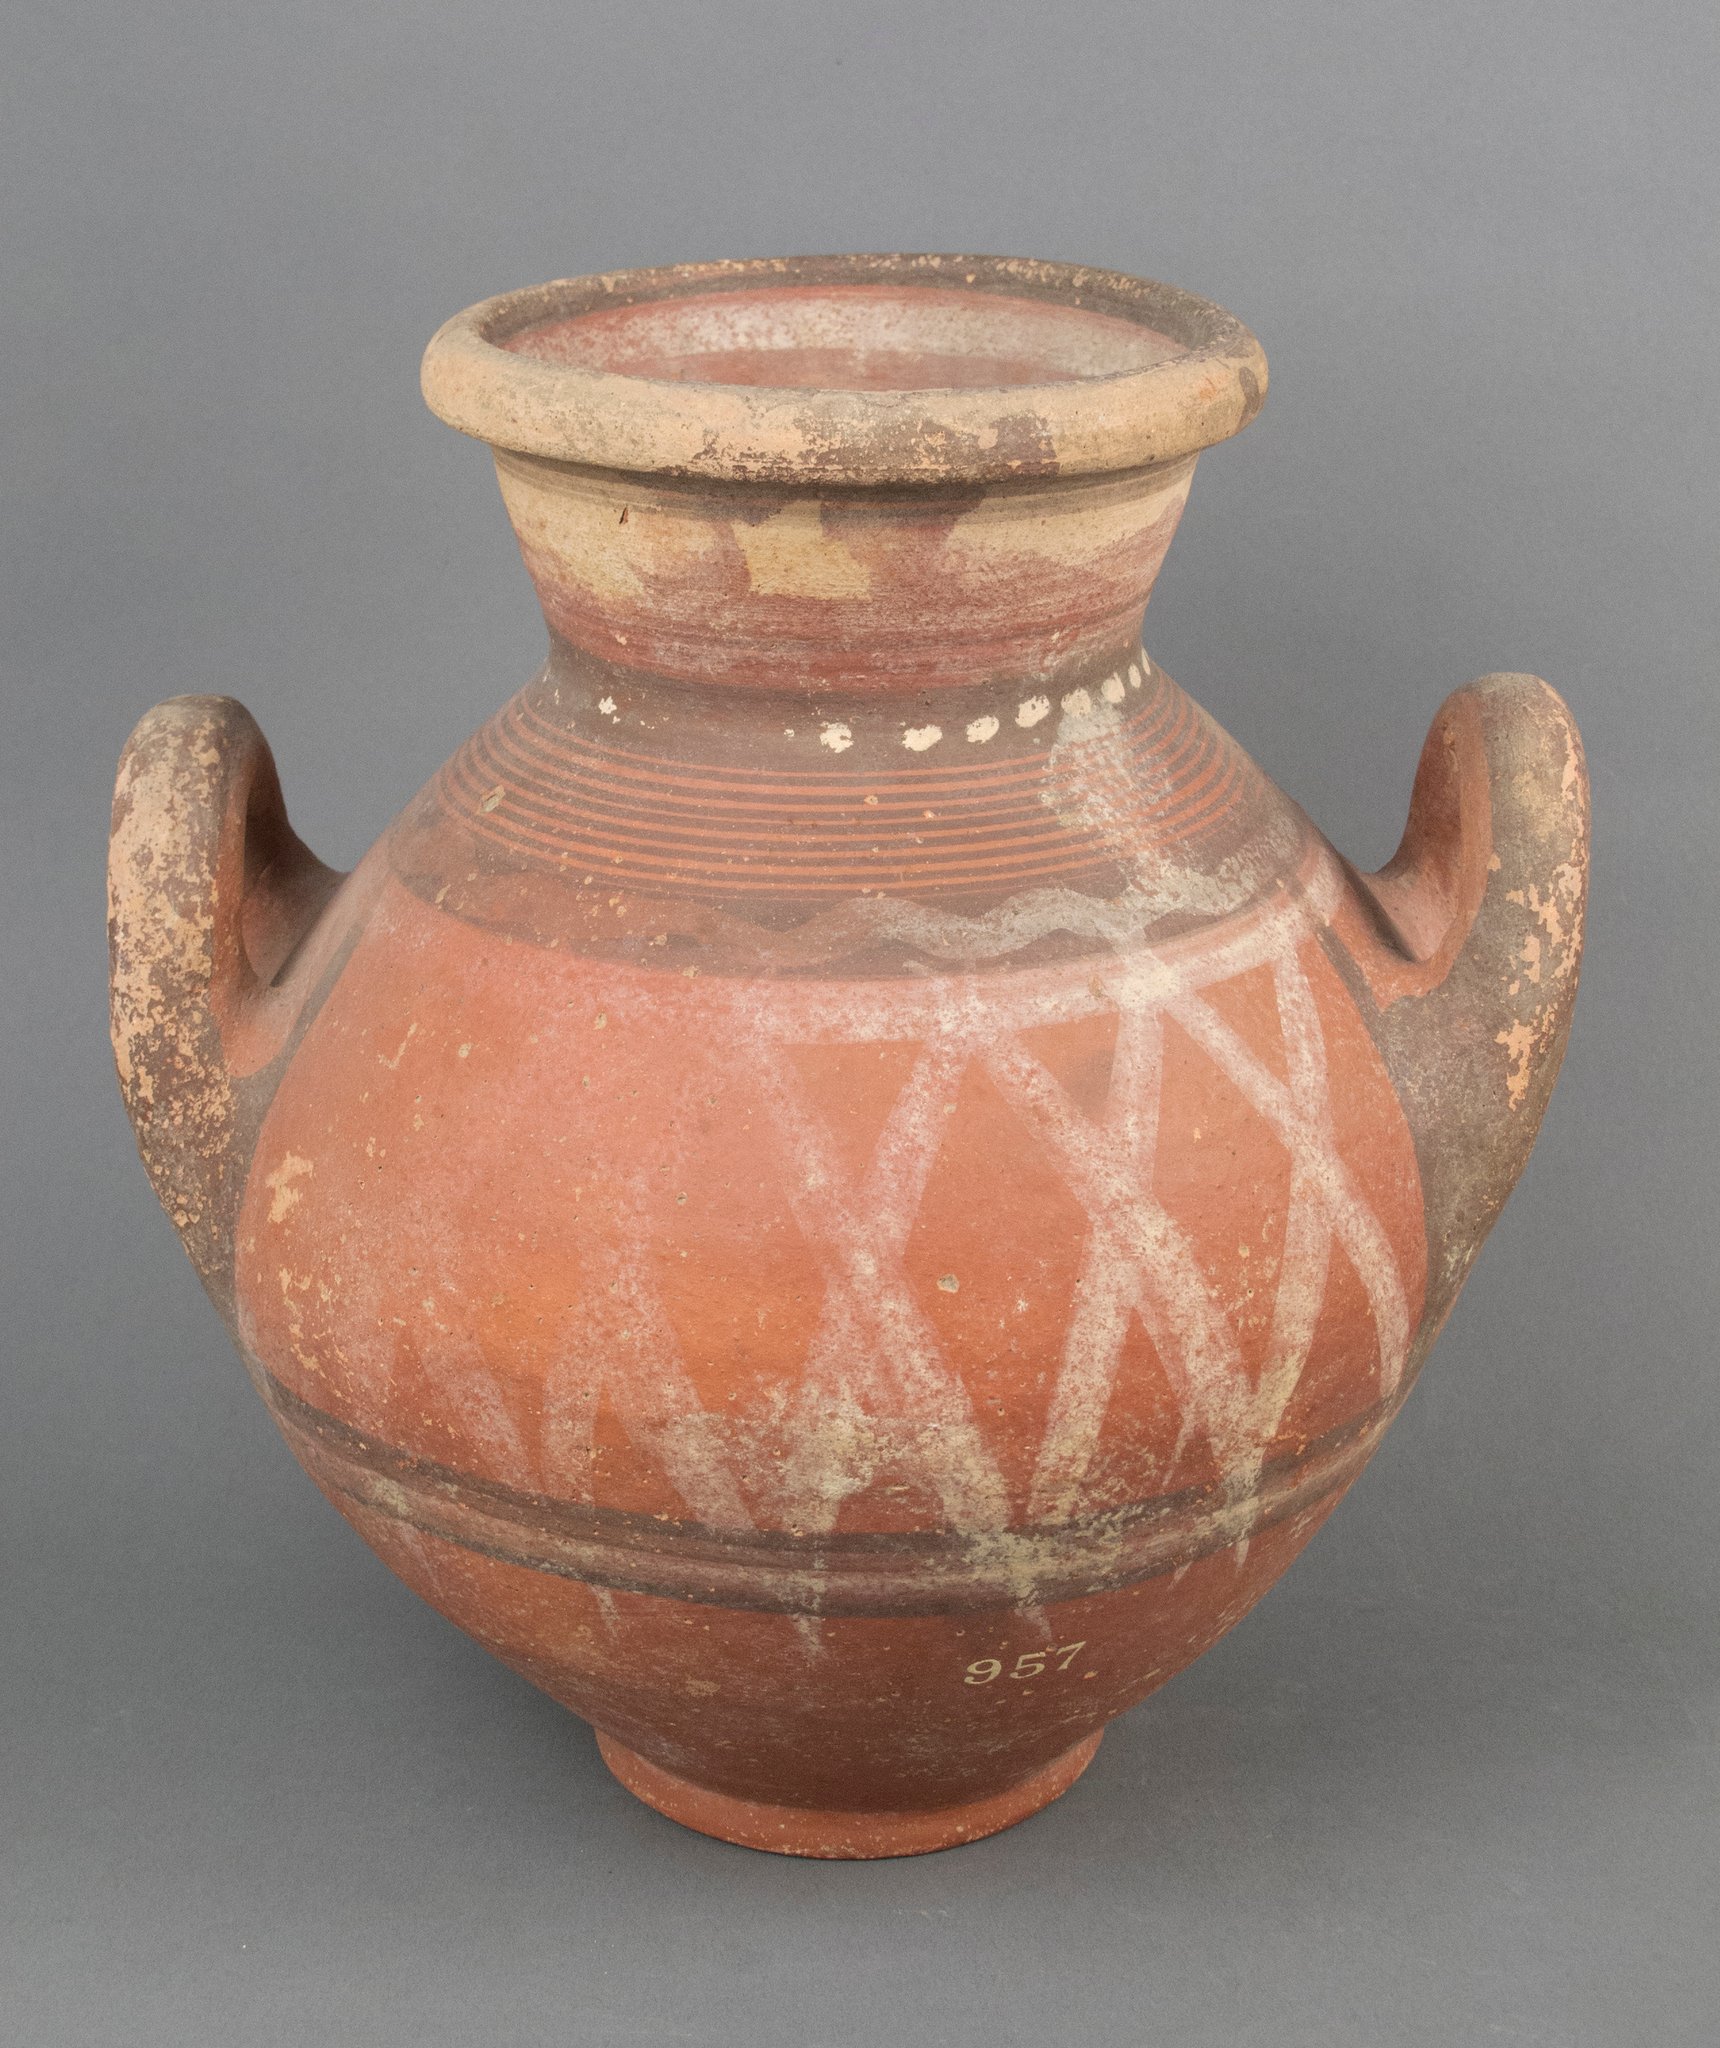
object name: amphora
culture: cypriot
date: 507-323 BCE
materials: terracotta